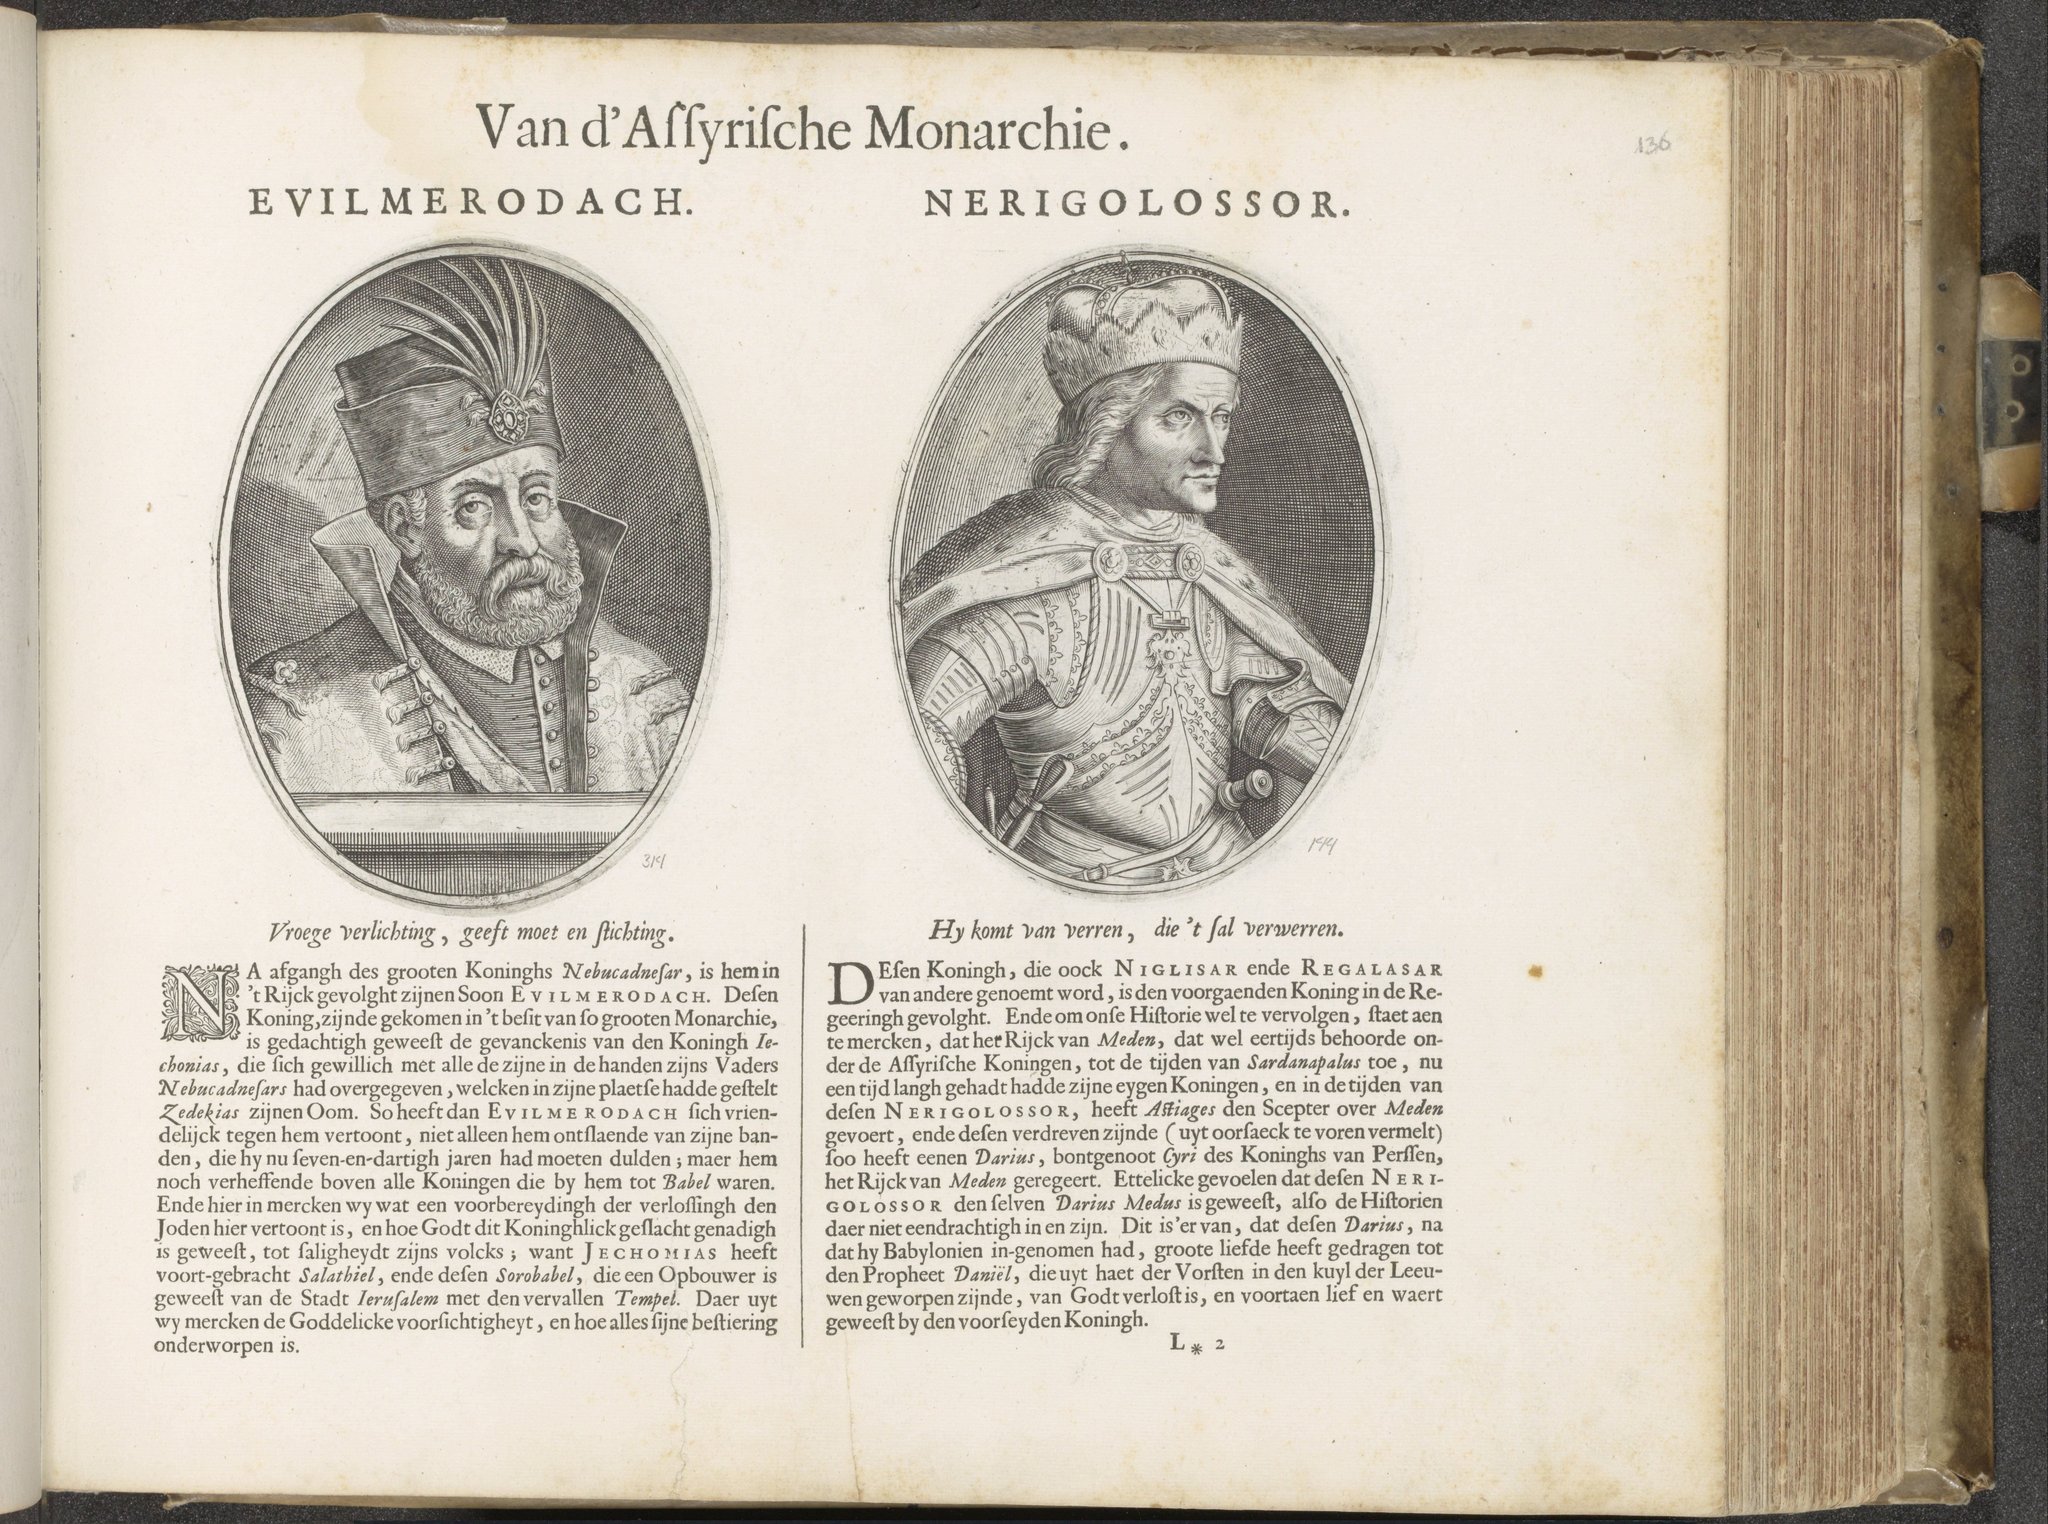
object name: album leaf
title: Van d'Assyrische monarchie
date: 1610-1625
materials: paper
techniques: engraving, letterpress printing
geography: amsterdam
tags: copenhagen (city), frederik iii (koning van denemarken en noorwegen)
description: Beide portretten werden oorspronkelijk uitgegeven door Nicolaes de Clerck in de periode 1610-1625. In de jaren zestig van de zeventiende eeuw werd het portret van Sigismund van Tirol nog eens gebruikt door de Amsterdamse uitgever Gillis Joosten Saeghman als afbeelding van koning Frederik III van Denemarken.